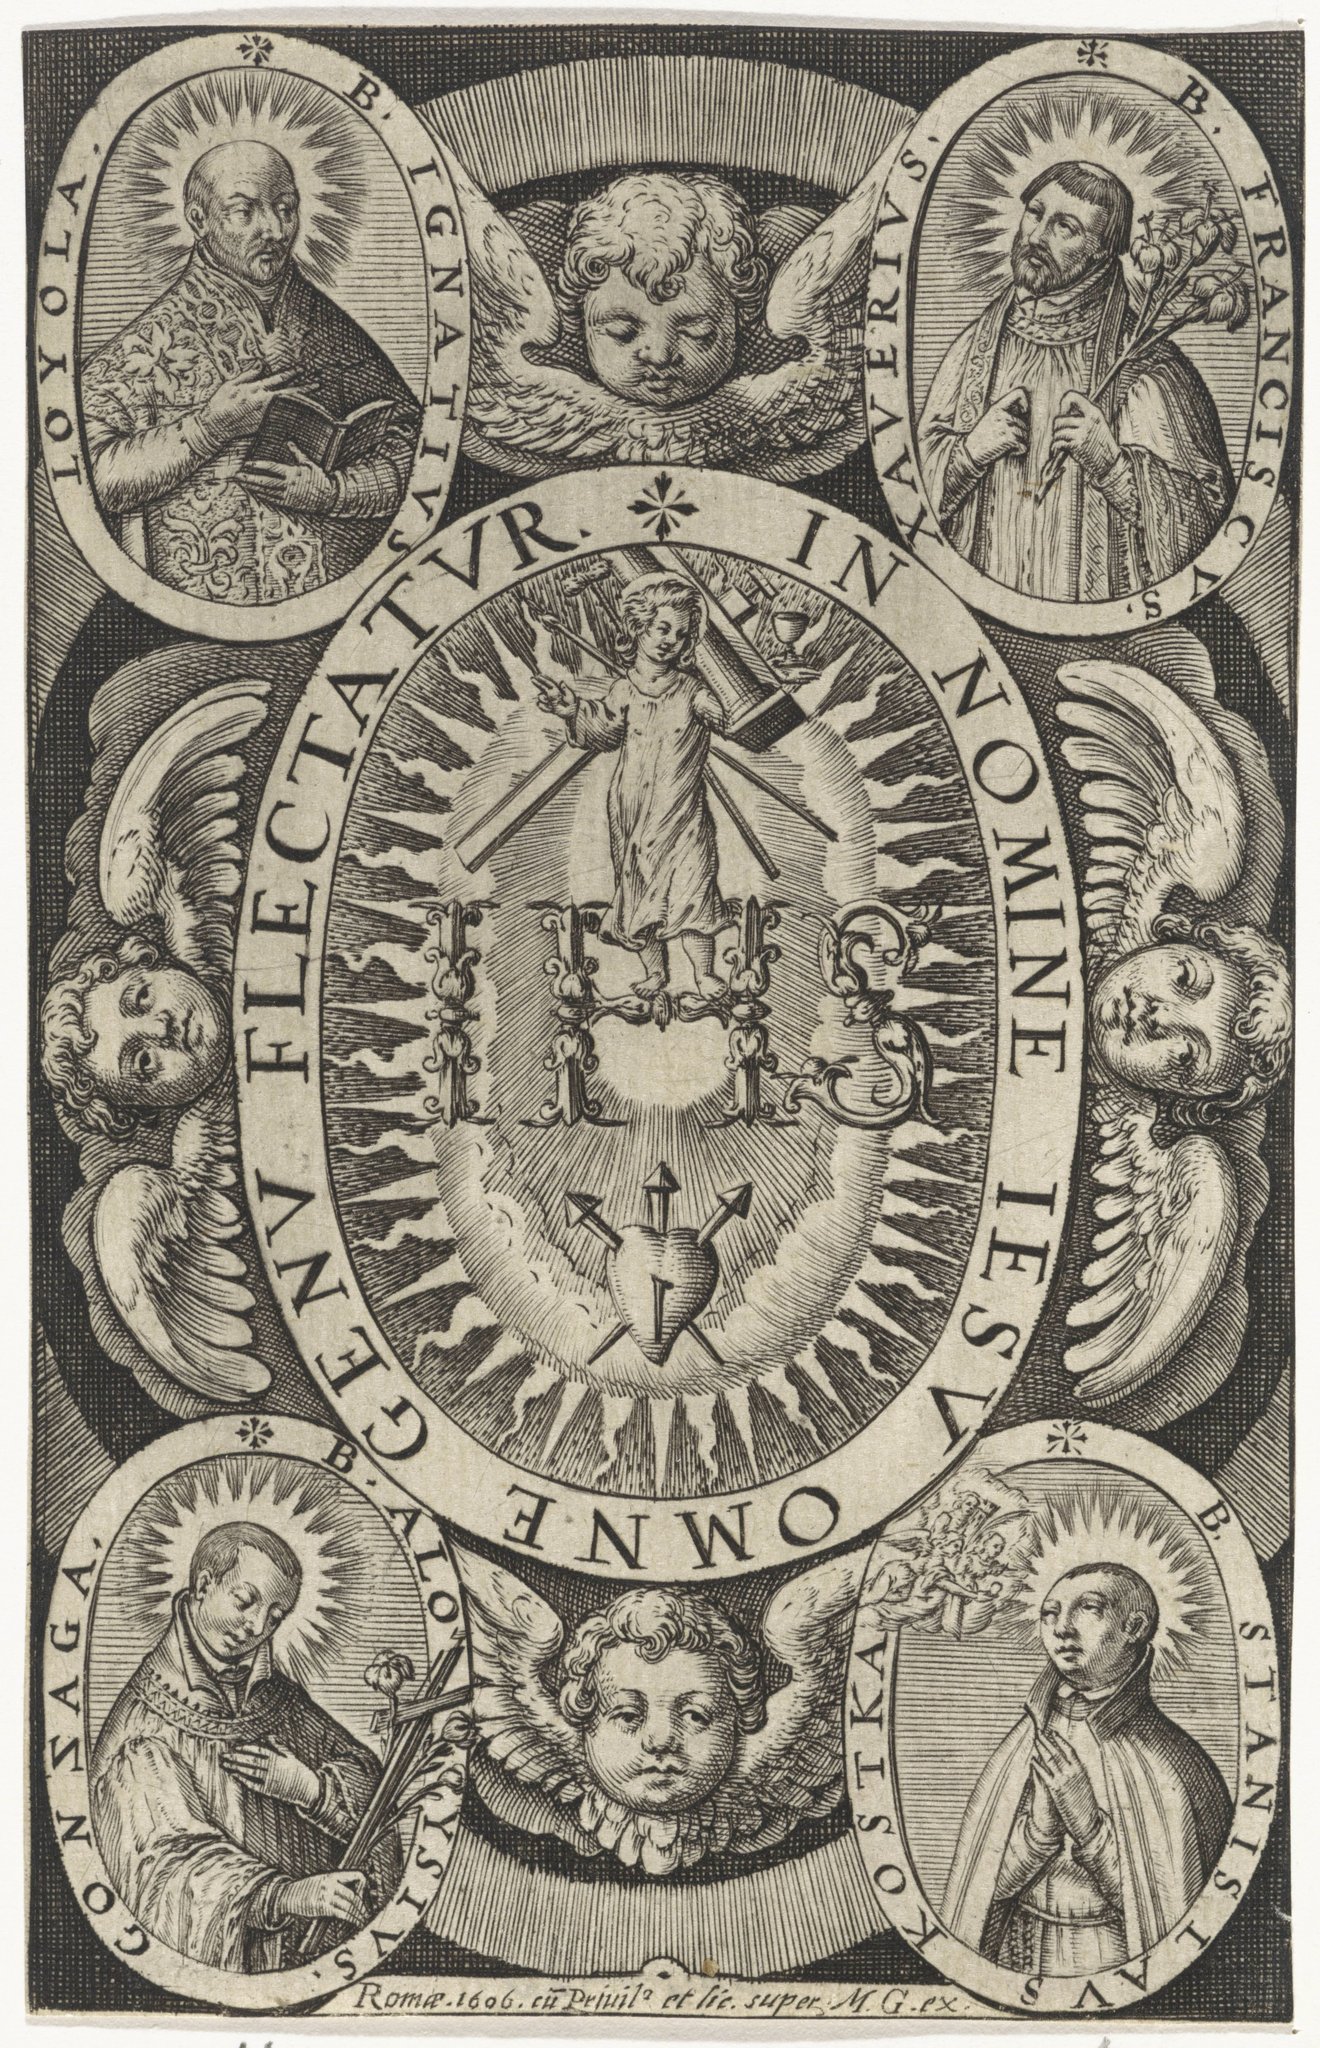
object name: print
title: Aanbidding van het Christuskind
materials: paper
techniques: engraving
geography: antwerp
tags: rome, clergyman, missionary, the jesuit friar aloysius gonzaga; possible attributes: crucifix, discipline, lily, skull, adoration of the name of jesus, the founder of the jesuit order, ignatius of loyola; possible attributes: book (with 'ad majorem dei gloriam'), demon, dragon under feet, flames, flaming heart, globe, ihs monogram, skull (with crown), tears in eyes, torch, the jesuit missionary francis xavier; possible attributes: cross, crucifix, flaming heart, indian, lily, torch, male saints (with name)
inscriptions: collector's mark: Lugt 240, number: ‘38. - 20’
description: Het Christuskind draagt de passiewerktuigen en staat op het monogram IHS. De voorstelling is gevat in een ovale omlijsting met een randschrift in het Latijn, omringd door vier cherubijnen. In de hoeken de busteportretten van vier Jezuïten: Ignatius van Loyola (linksboven), Francis Xavier (rechtsboven), Aloysius Gonzaga (linksonder) en Stanislaus Kostka (rechtsonder).